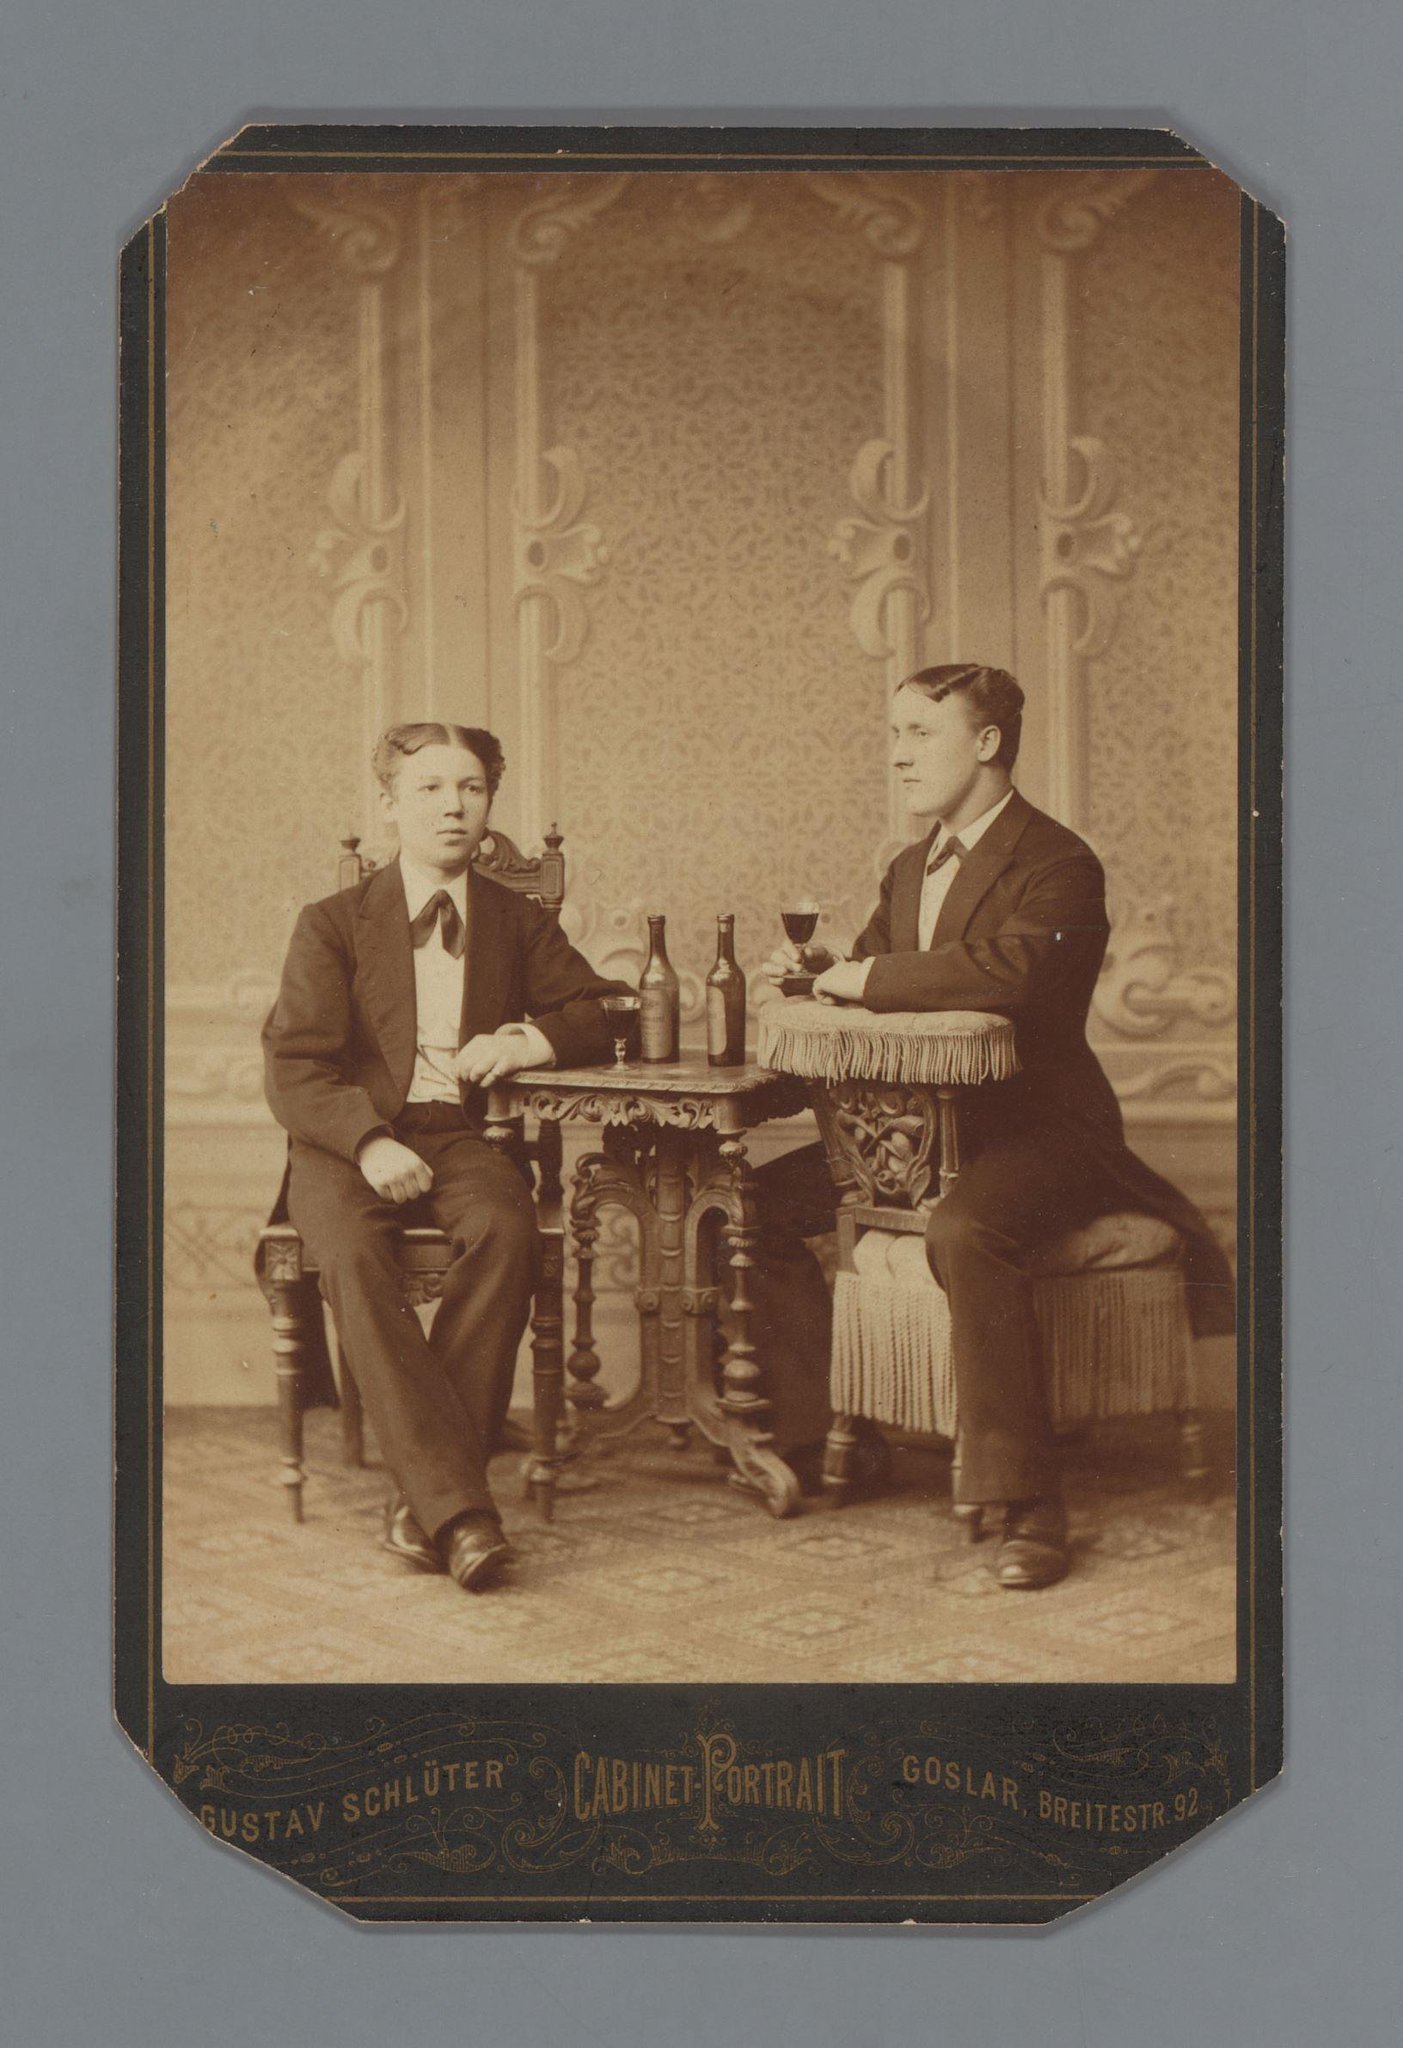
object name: cabinet photograph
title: Studioportret van twee onbekende mannen aan een tafel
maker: gustav schlüter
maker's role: fotograaf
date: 1870-1895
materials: cardboard, photographic support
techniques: albumen print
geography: goslar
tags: studio ~ photographer, adult man, table